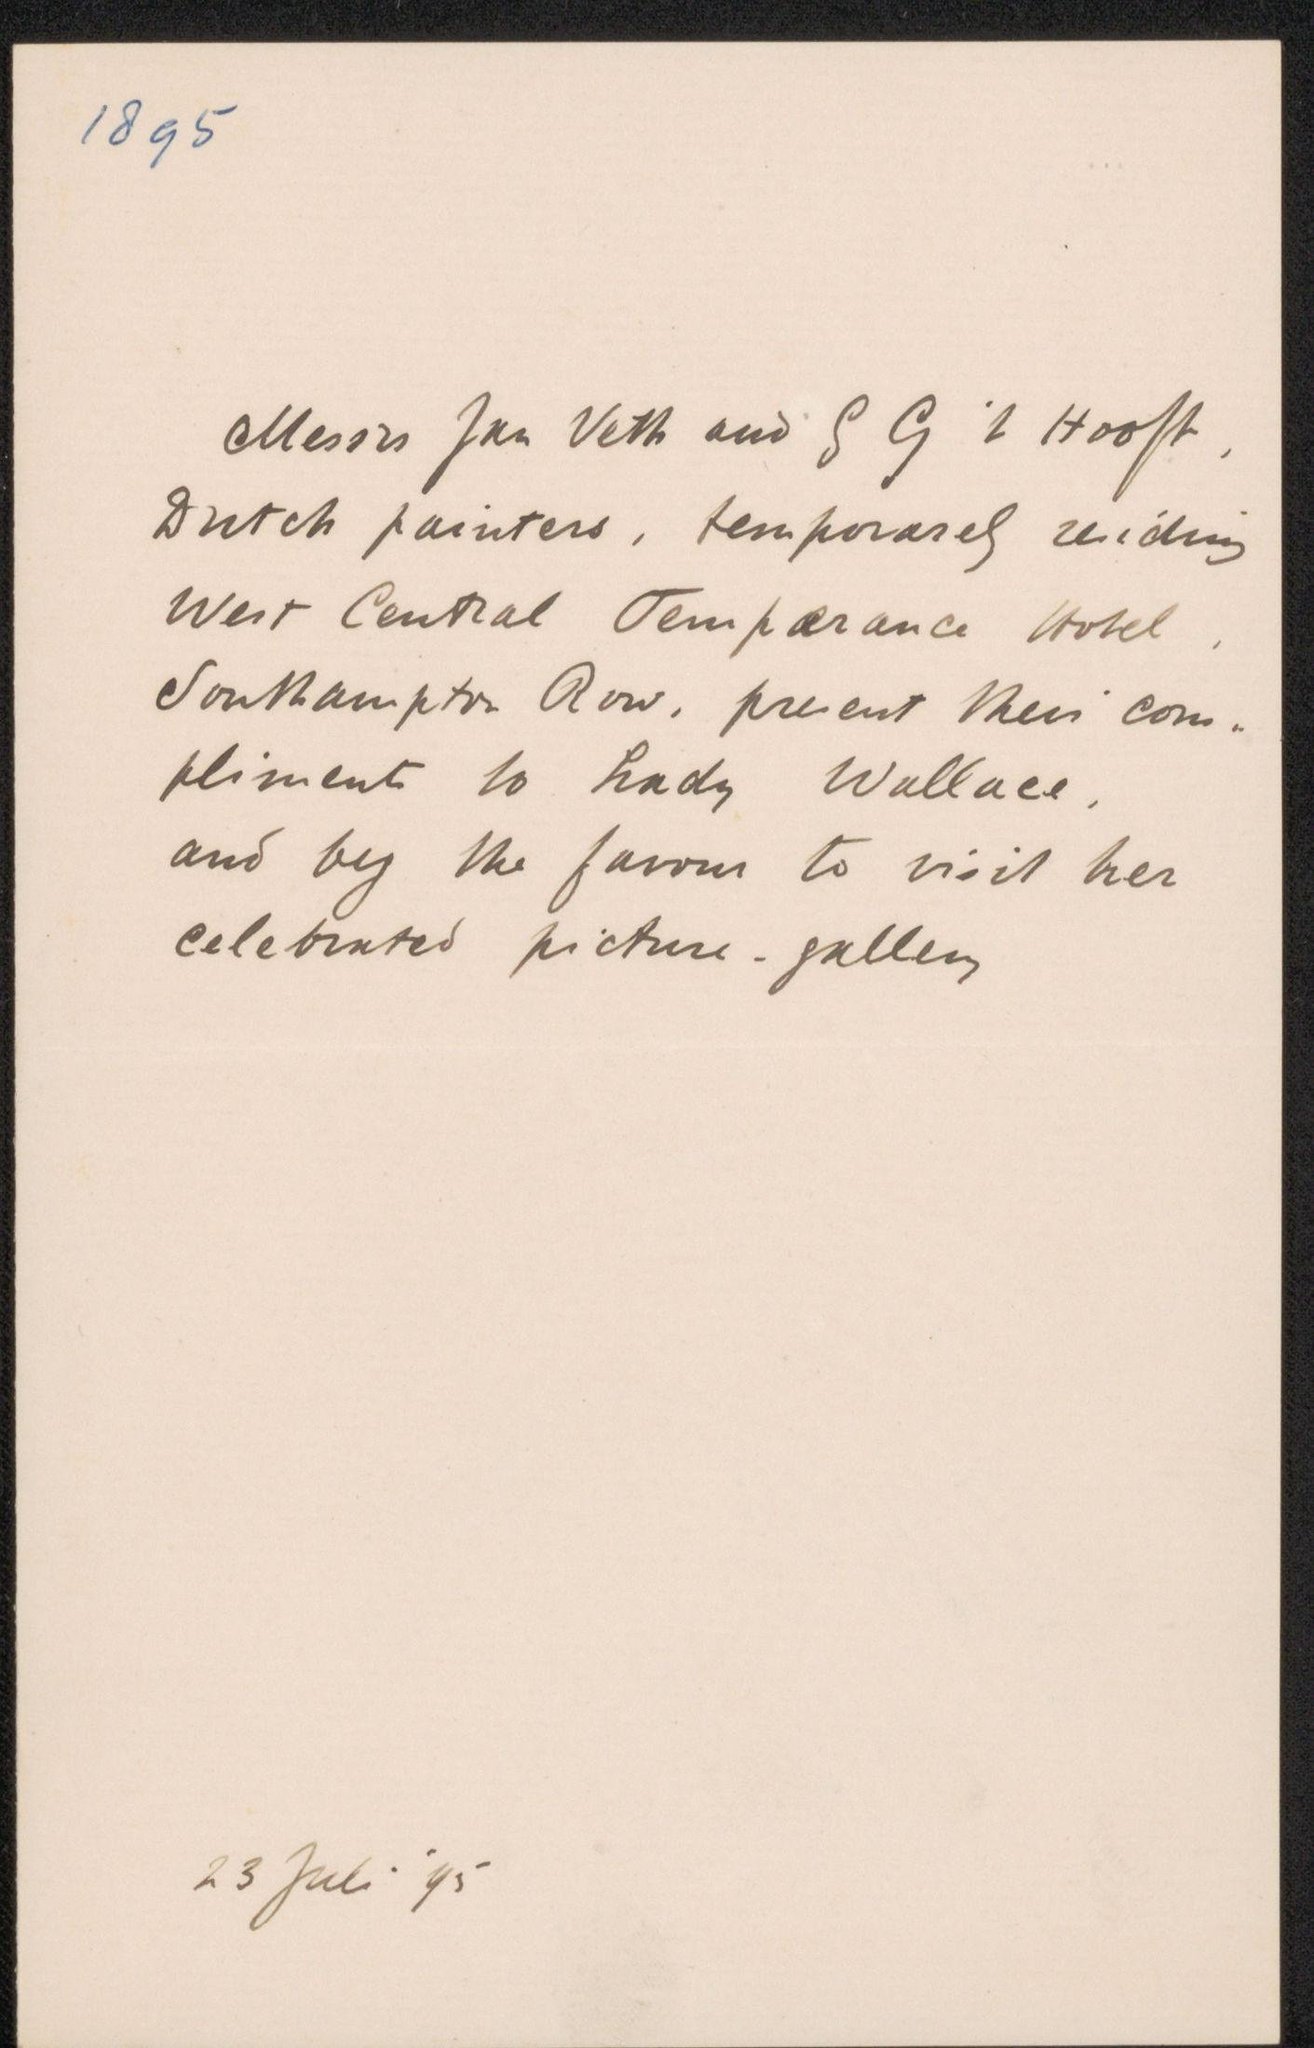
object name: letter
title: Brief aan Amélie-Julie-Charlotte Castelnau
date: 1895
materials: ink, paper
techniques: pen, writing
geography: london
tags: painting (including book-illumination, miniature-painting), exhibition ~ art, london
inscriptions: watermark, collector's mark: ‘RPK’